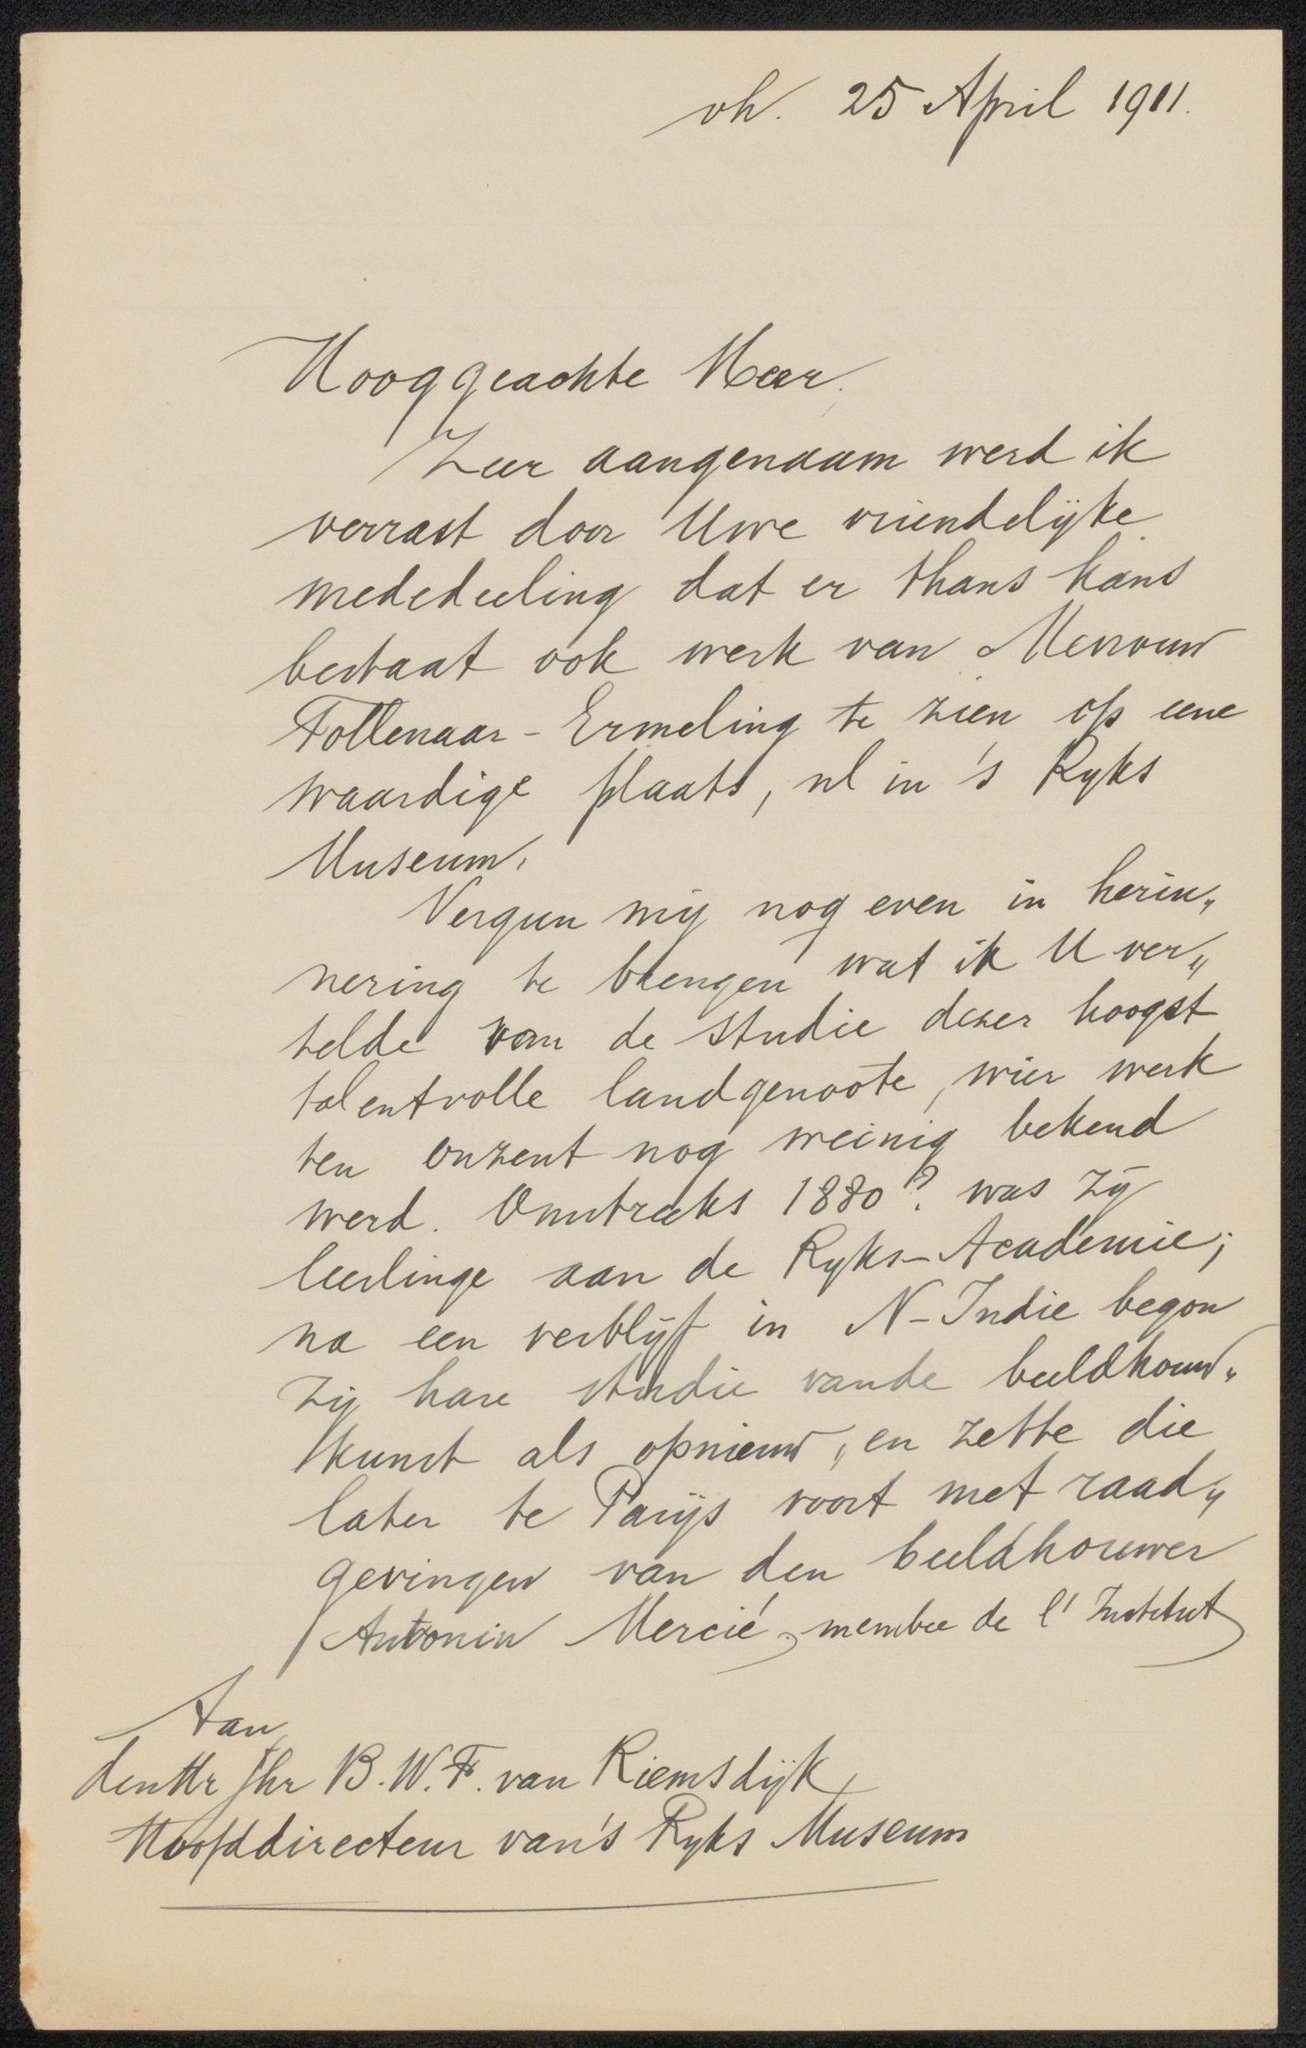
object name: letter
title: Brief aan jonkheer Barthold Willem Floris van Riemsdijk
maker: august allebé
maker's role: draughtsman, print maker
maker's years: 1838-1927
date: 1911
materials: ink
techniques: pen, writing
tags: the hague, draughtsman, sculptor, annie ermeling, maastricht, amsterdam, print maker, engineer, jonkheer barthold willem floris van riemsdijk, painter, marius jean antonin mercié, rijksmuseum amsterdam, sculpture, art collecting, historical persons (portraits and scenes from the life), dutch east indies, the, paris